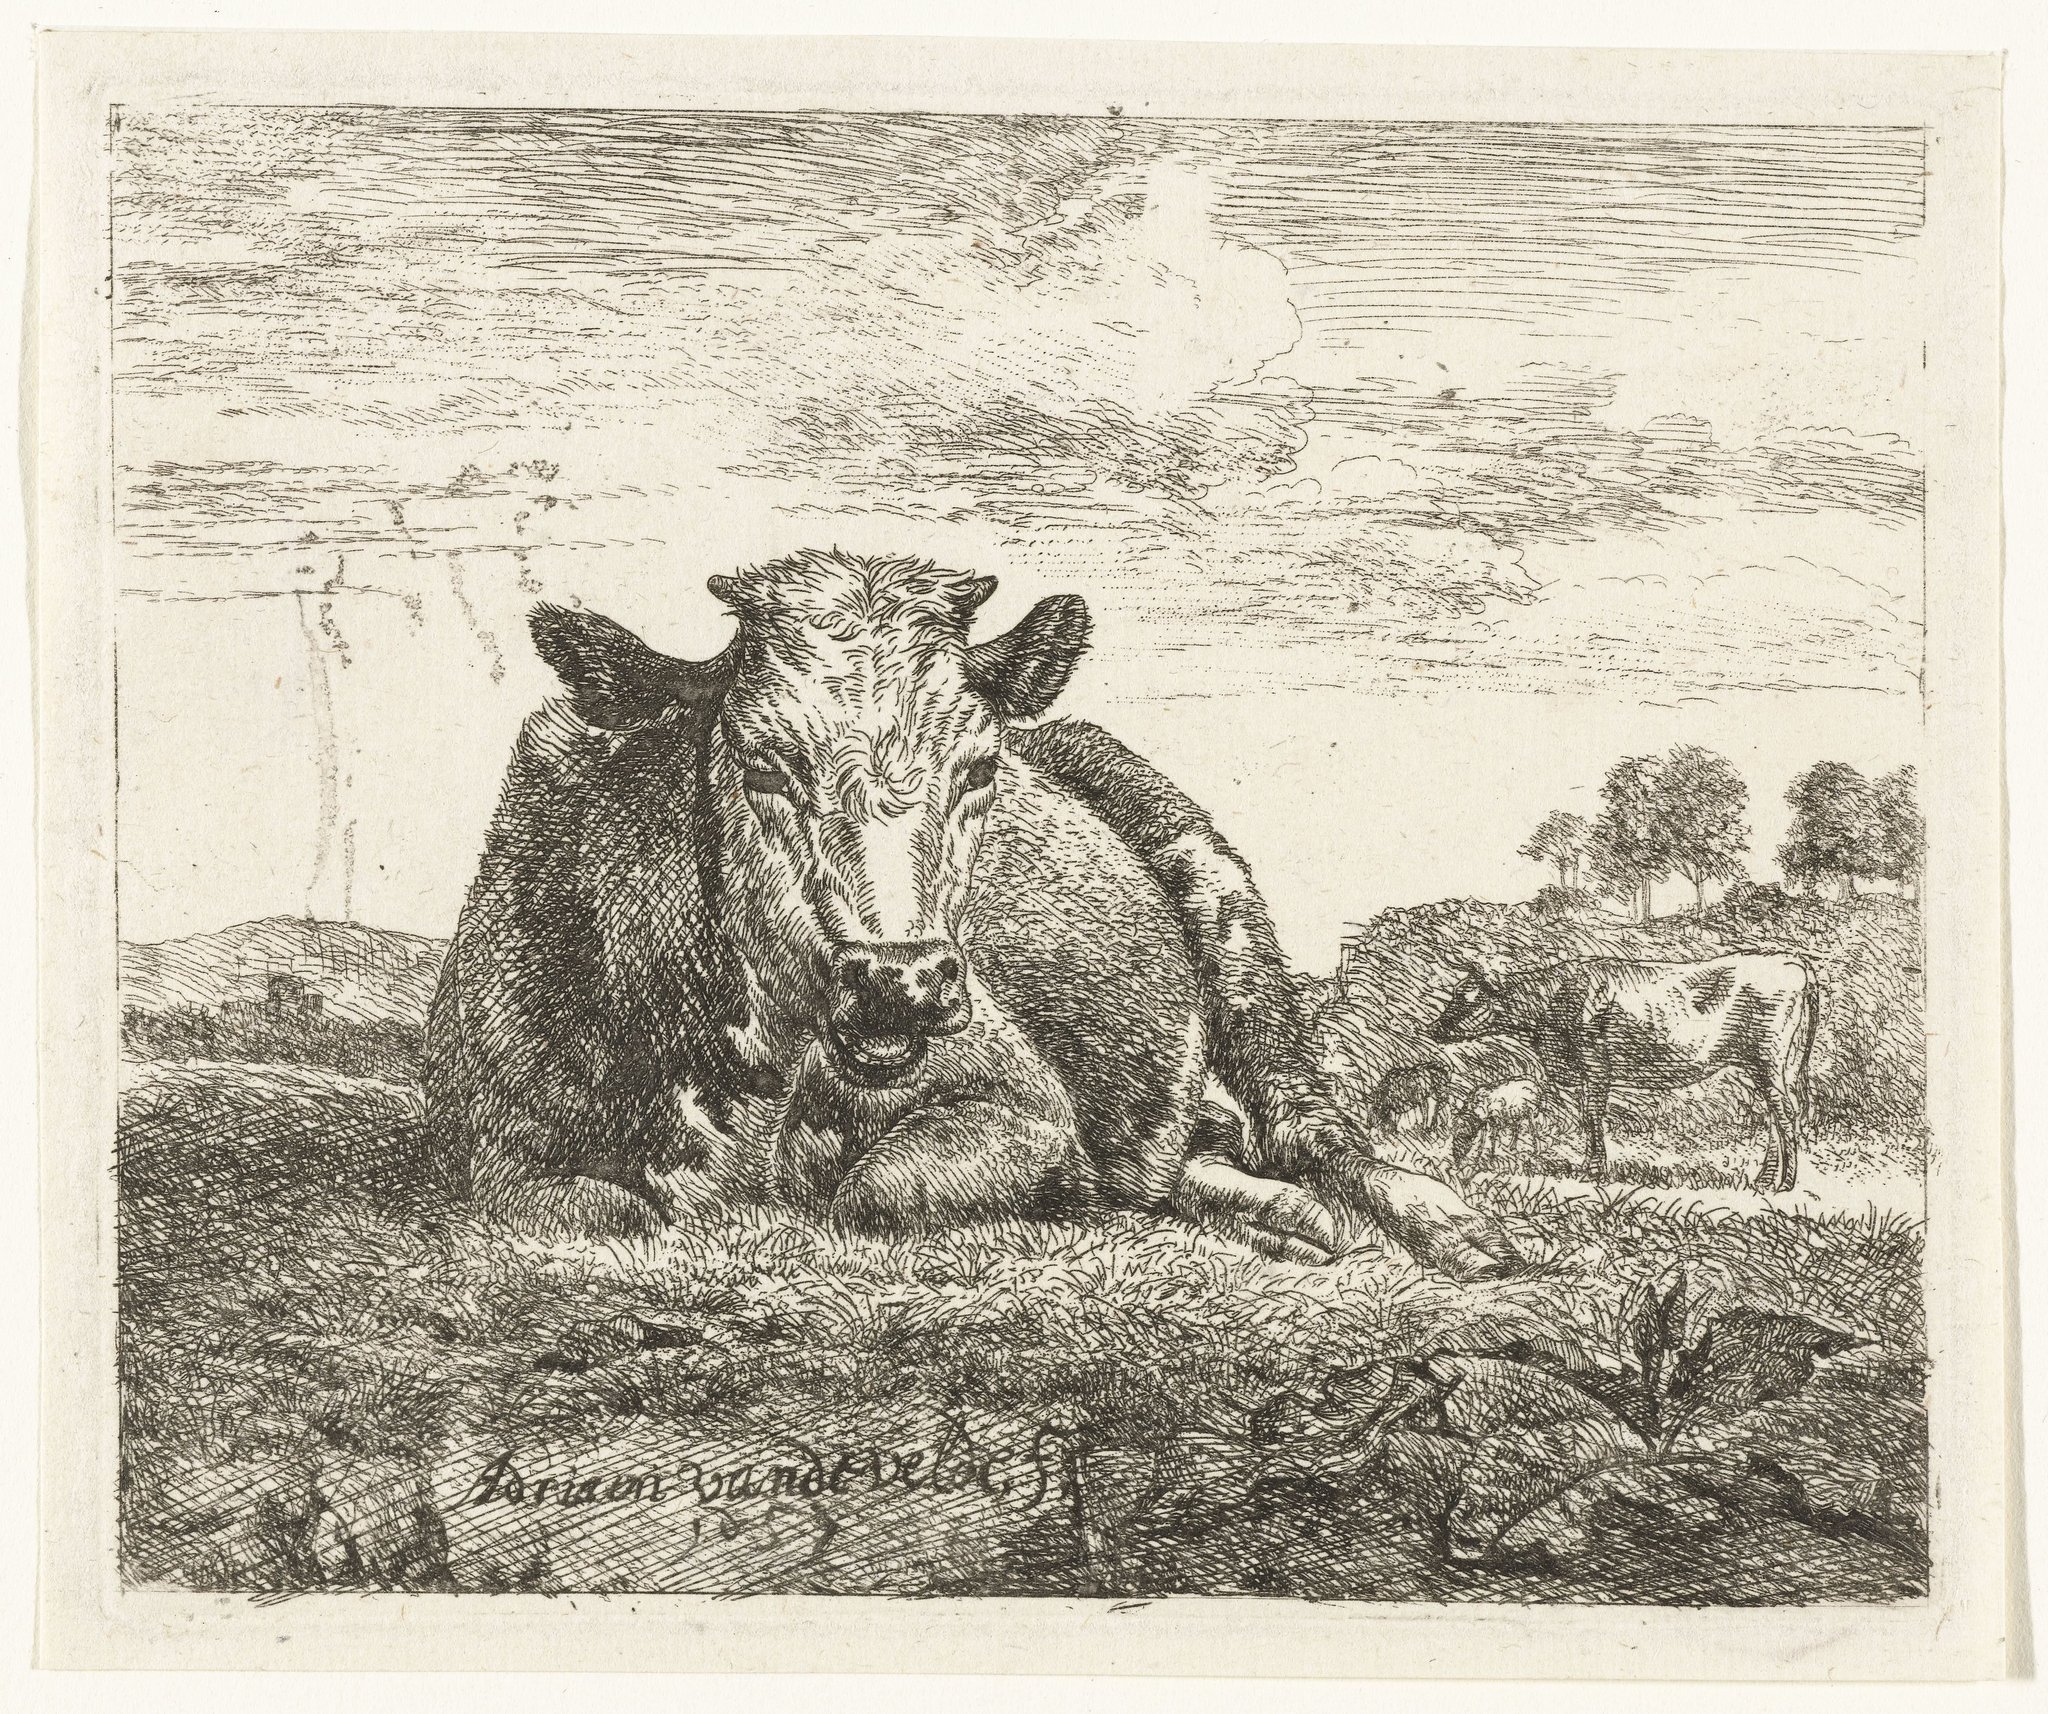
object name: print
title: Liggende koe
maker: adriaen van de velde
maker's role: draughtsman, painter, print maker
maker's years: 1636-1672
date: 1657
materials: paper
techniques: etching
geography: amsterdam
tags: cow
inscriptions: collector's mark: Lugt 240